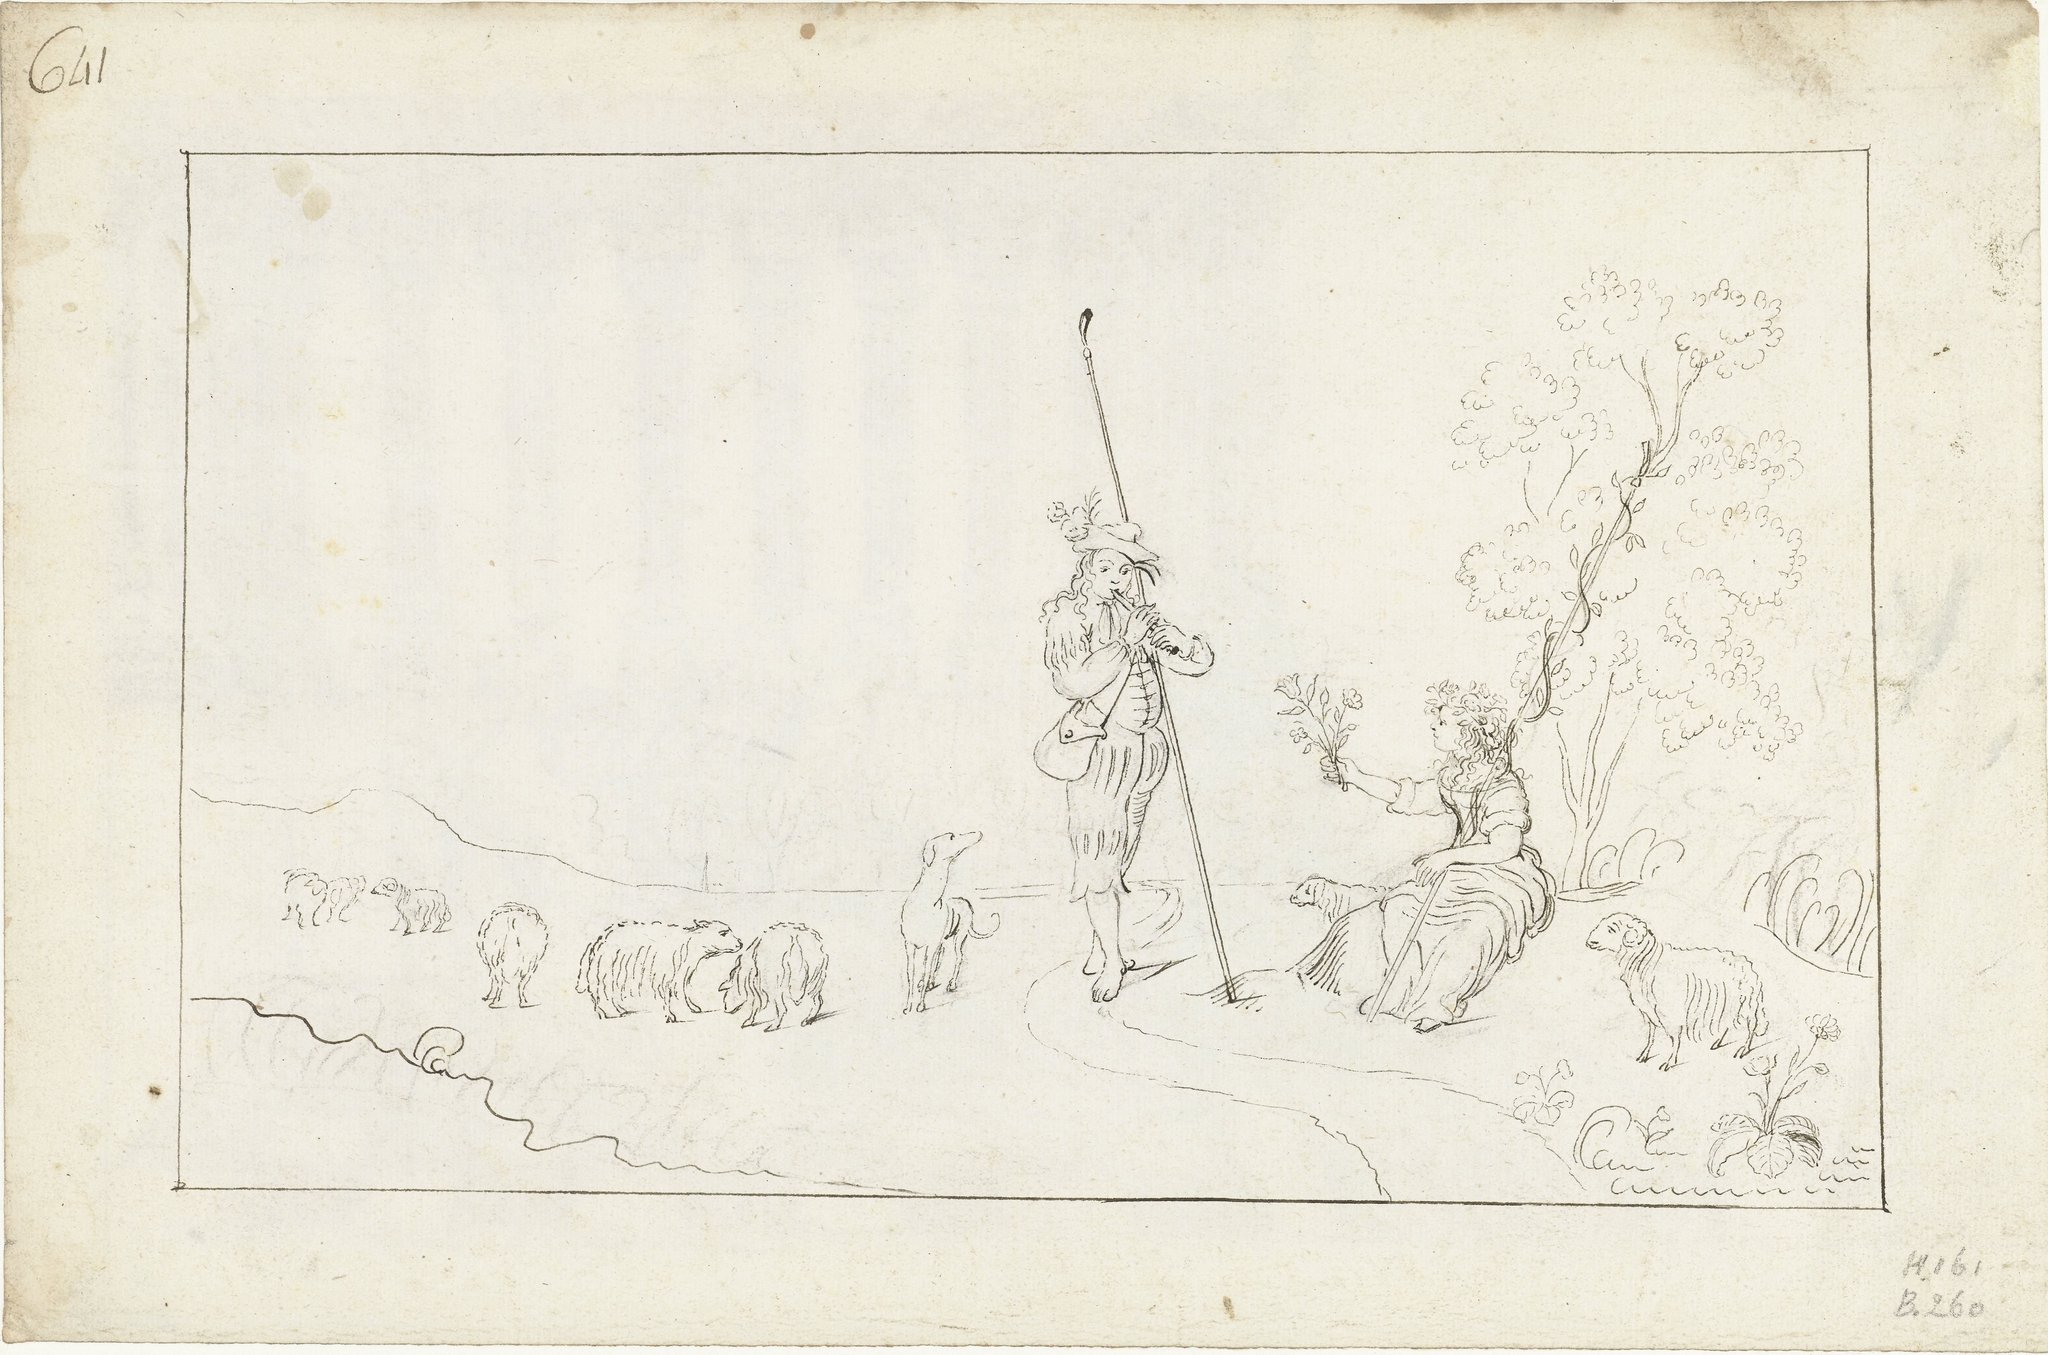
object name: drawing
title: Pastorale scène met herder en herderin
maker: gesina ter borch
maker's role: draughtsman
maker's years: 1633-1690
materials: chalk, ink, paper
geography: zwolle